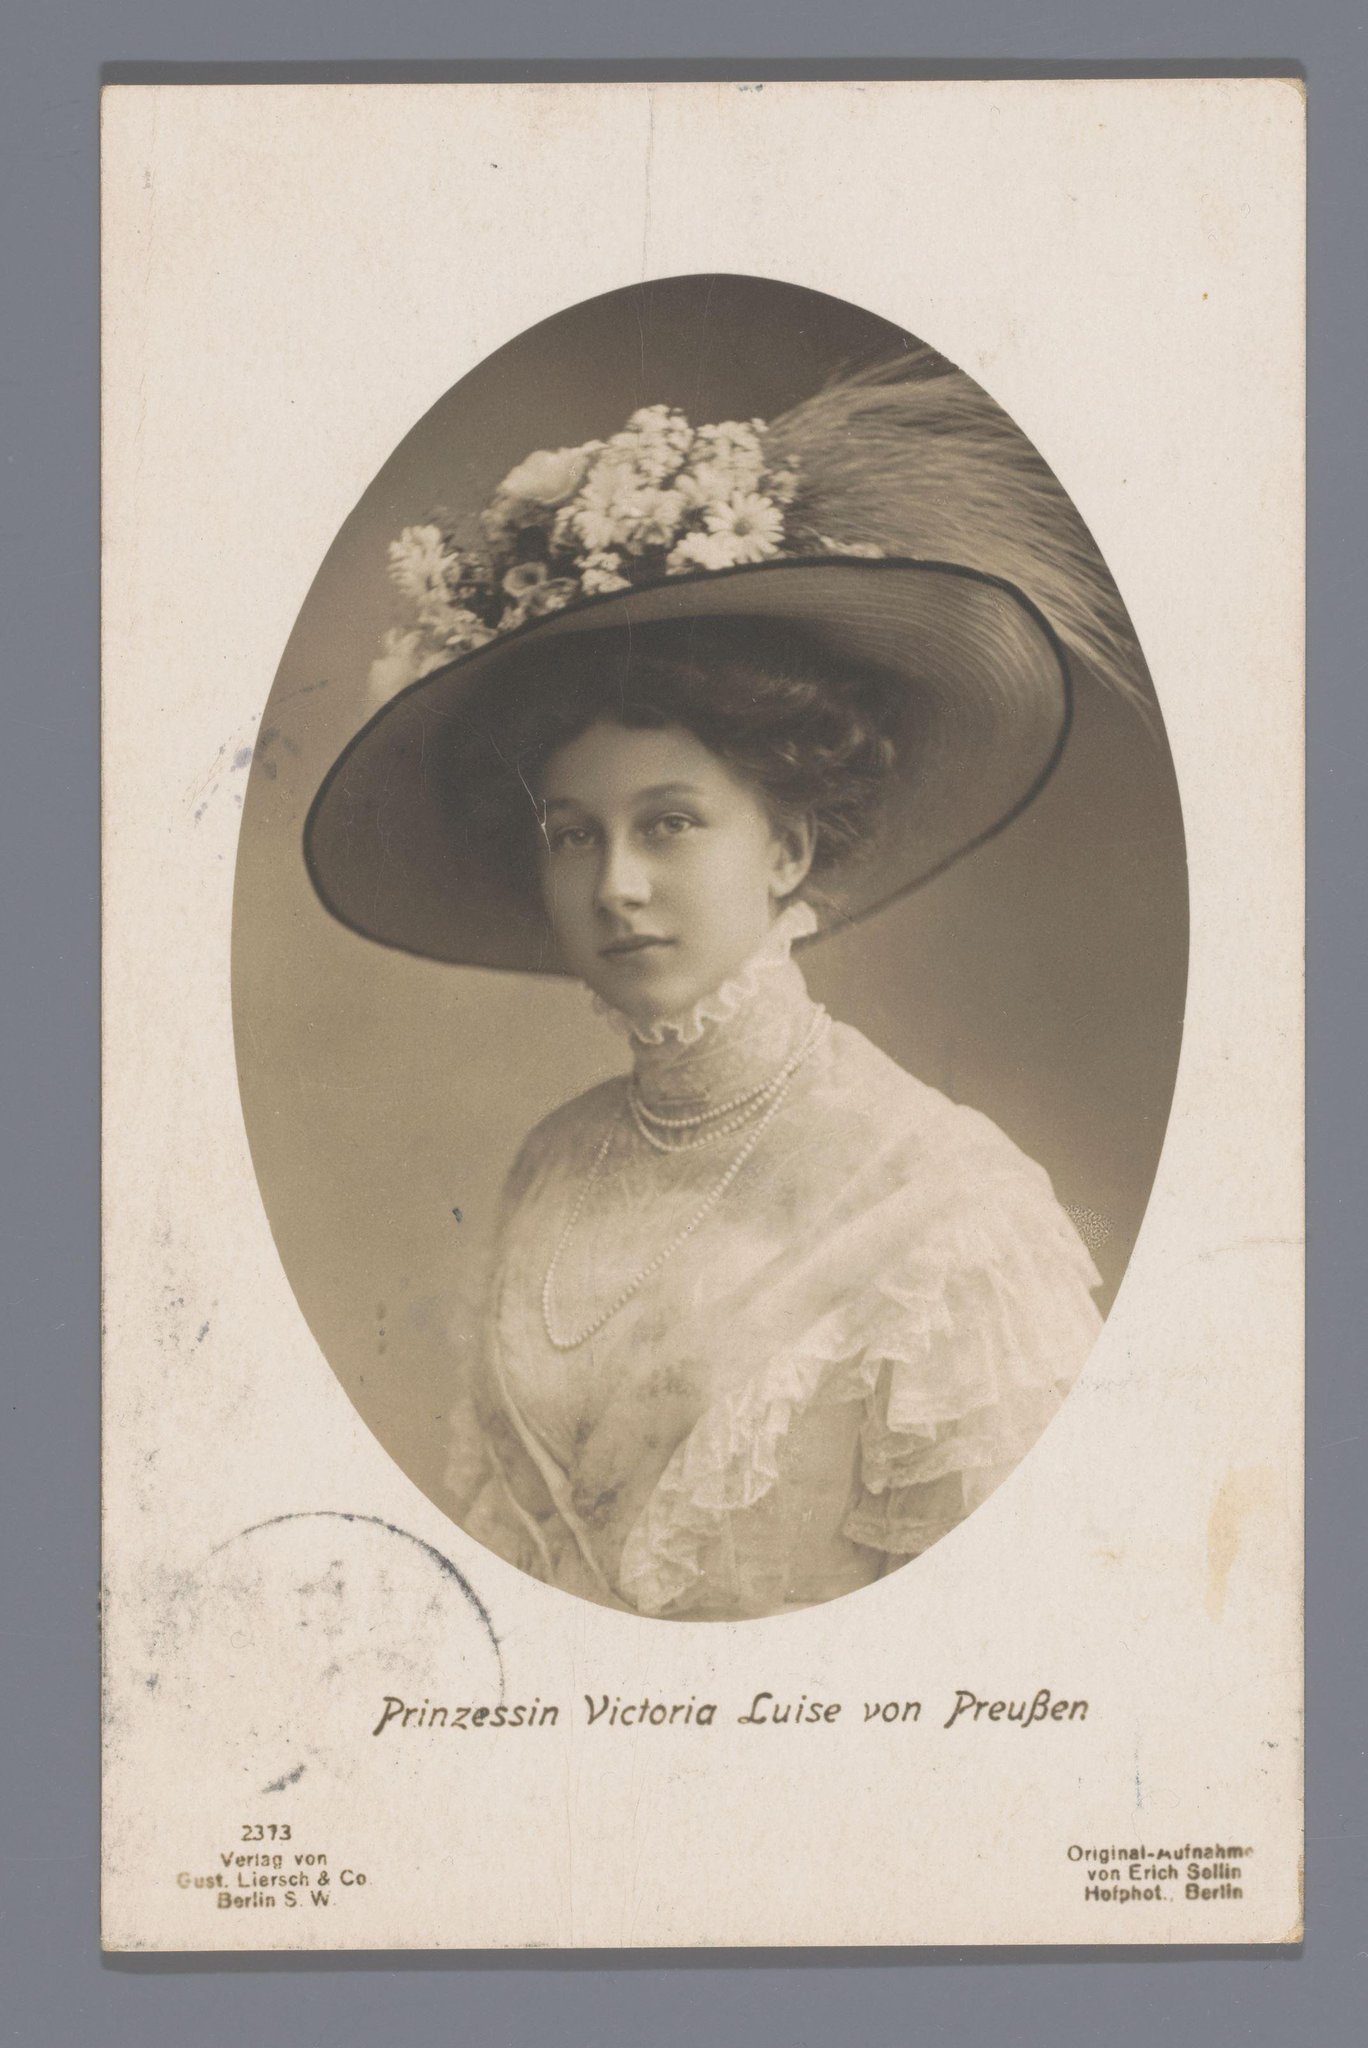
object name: photograph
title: Prinzessin Victoria Luise von Preußen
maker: erich sellin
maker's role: fotograaf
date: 1910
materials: paper, cardboard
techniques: gelatin silver print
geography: berlin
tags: historical persons, princess, berlin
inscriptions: inscription, inscription: ‘Original-Aufnahme/ von Erich Sellin/ Hofphot. Berlin’, inscription: ‘2373/ Verlag von/ Gust. Liersch. & Co/ Berlin S.W.’